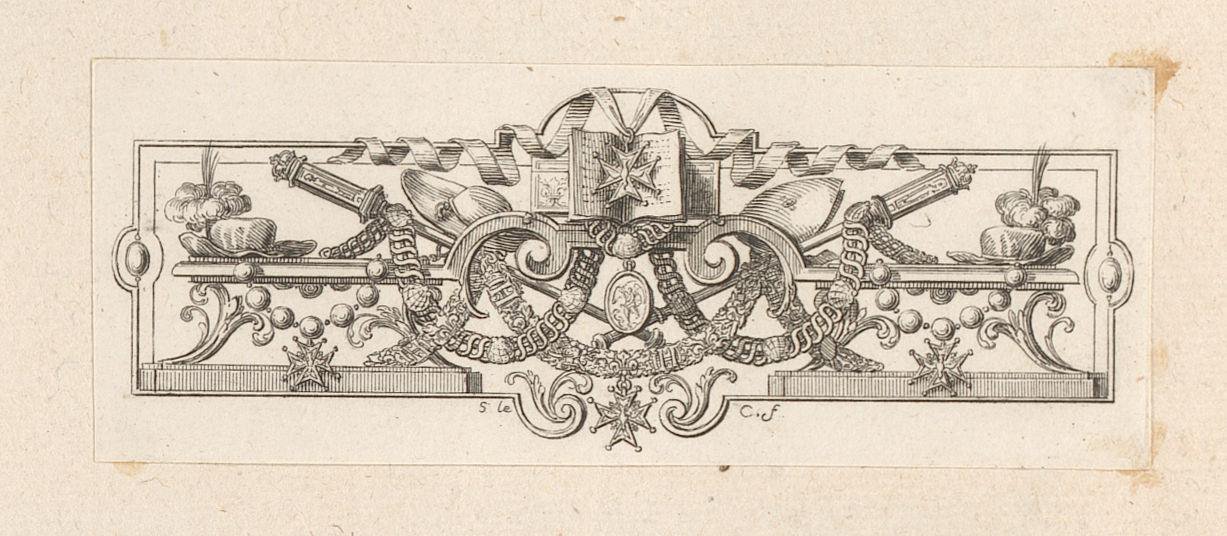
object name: album leaf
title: Vignet met de onderscheiding van de Orde van de Heilige Geest en overige attributen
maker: sébastien leclerc (i)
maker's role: print maker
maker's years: 1637-1714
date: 1703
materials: paper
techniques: etching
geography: paris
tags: knighthood order of the holy spirit - insignia of a knighthood order, e.g.: badge, chain (with name of order)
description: Prent gebruikt voor: Les Statuts de l'ordre du Saint-Esprit. Parijs: Imprimerie Royale, 1703.